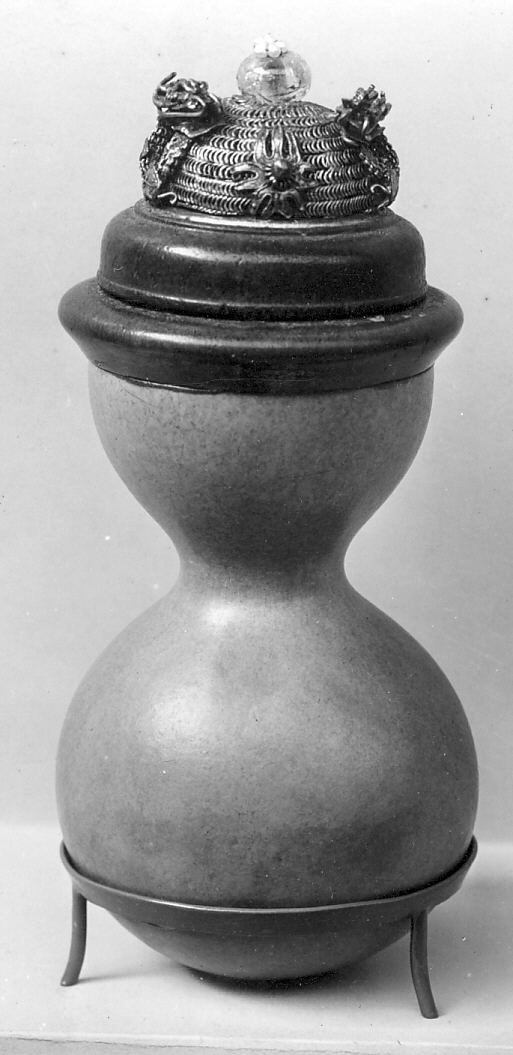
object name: cricket cage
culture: chinese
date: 1701-1900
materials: metal, wood